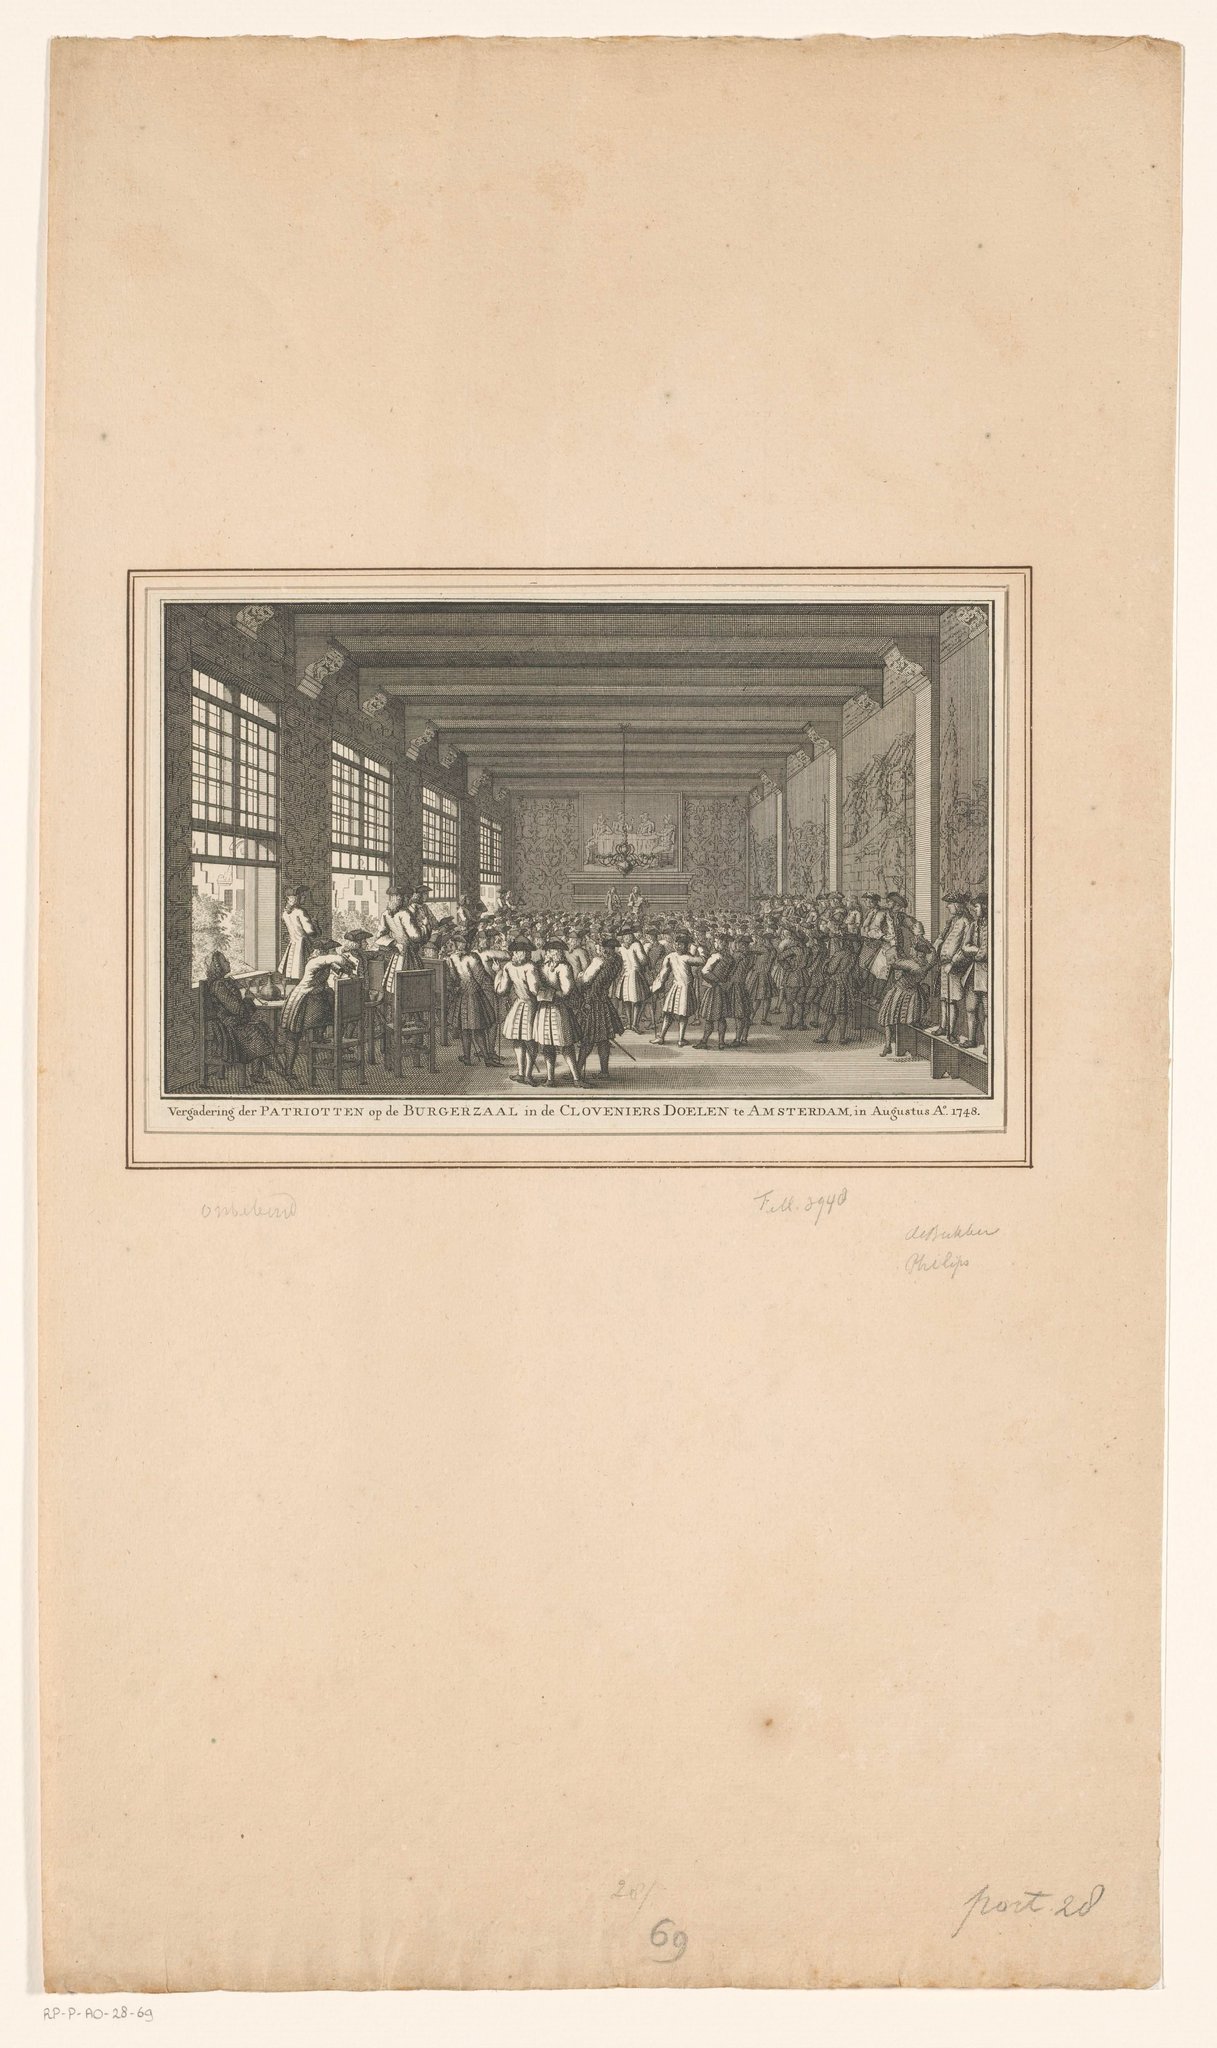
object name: print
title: Bijeenkomst van de Doelisten in de Kloveniersdoelen, 1748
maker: Anonymous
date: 1748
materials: paper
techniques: engraving, etching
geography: northern netherlands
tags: meeting, assembly, political meeting, propaganda meeting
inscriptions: collector's mark: Lugt 2228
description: Prent mogelijk ook gebruikt in: Korte schets of dag-verhaal van het tegenwoordig gedrag der burgeren van Amsterdam (…). S.l.: s.n., 1748. En mogelijk ook in: Het ontroerd Holland. Of kort verhaal van de voornaamste onlusten, oproeren en oneenigheden (…). 3 delen. Harderwijk: Willem Brinkink, s.a. [1748-1750], dl. 3.